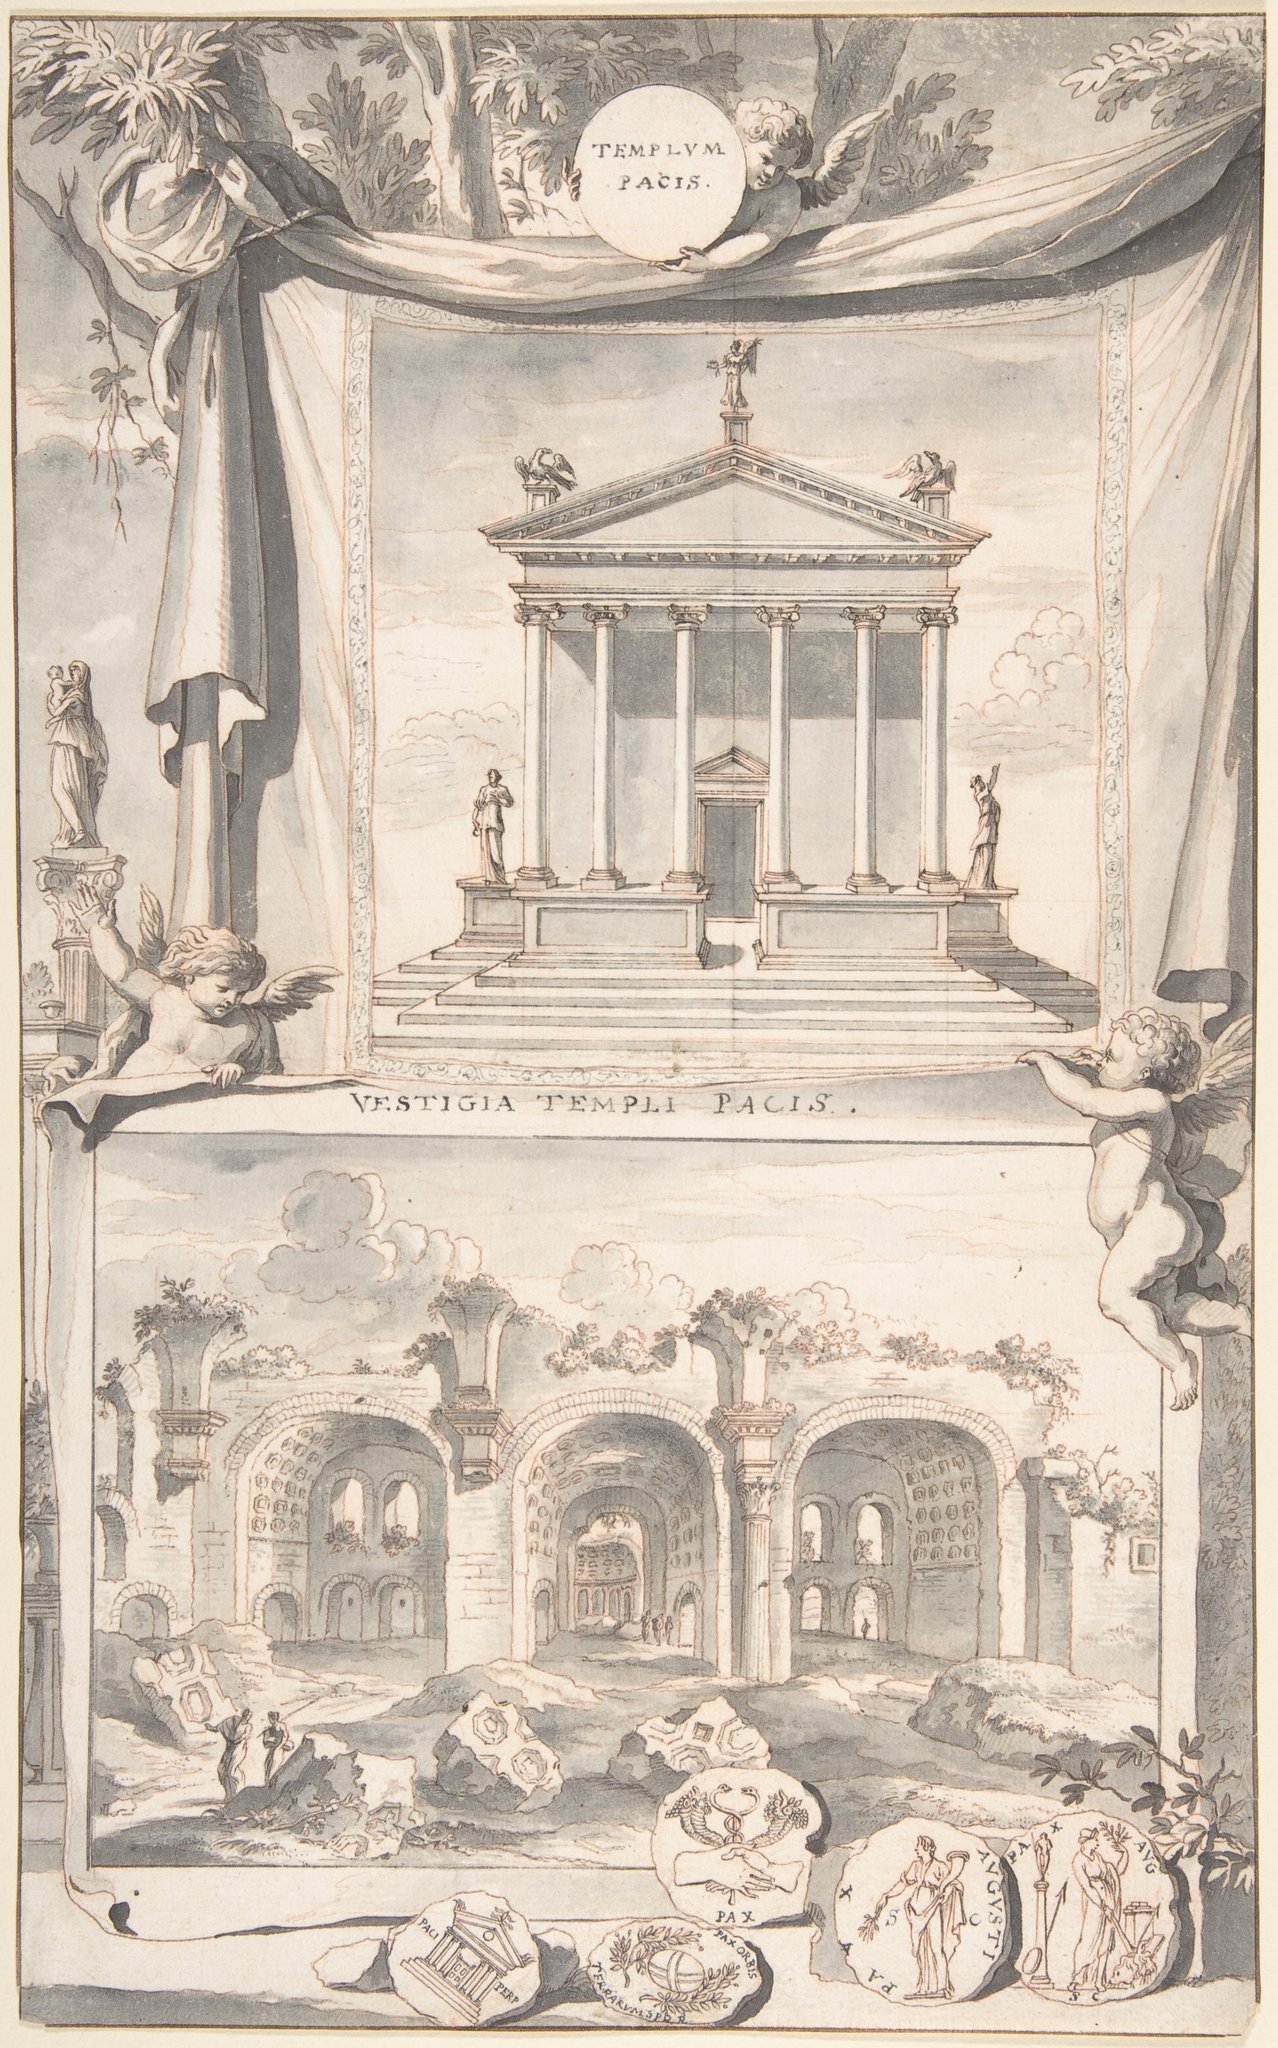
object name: drawing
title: A Reconstruction of the Templum Pacis (above) and a View of the Ruins (below)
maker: jan goeree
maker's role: artist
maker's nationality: dutch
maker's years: 1670-1731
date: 1704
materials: chalk, ink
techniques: brush, pen, wash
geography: italy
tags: architecture,ruins